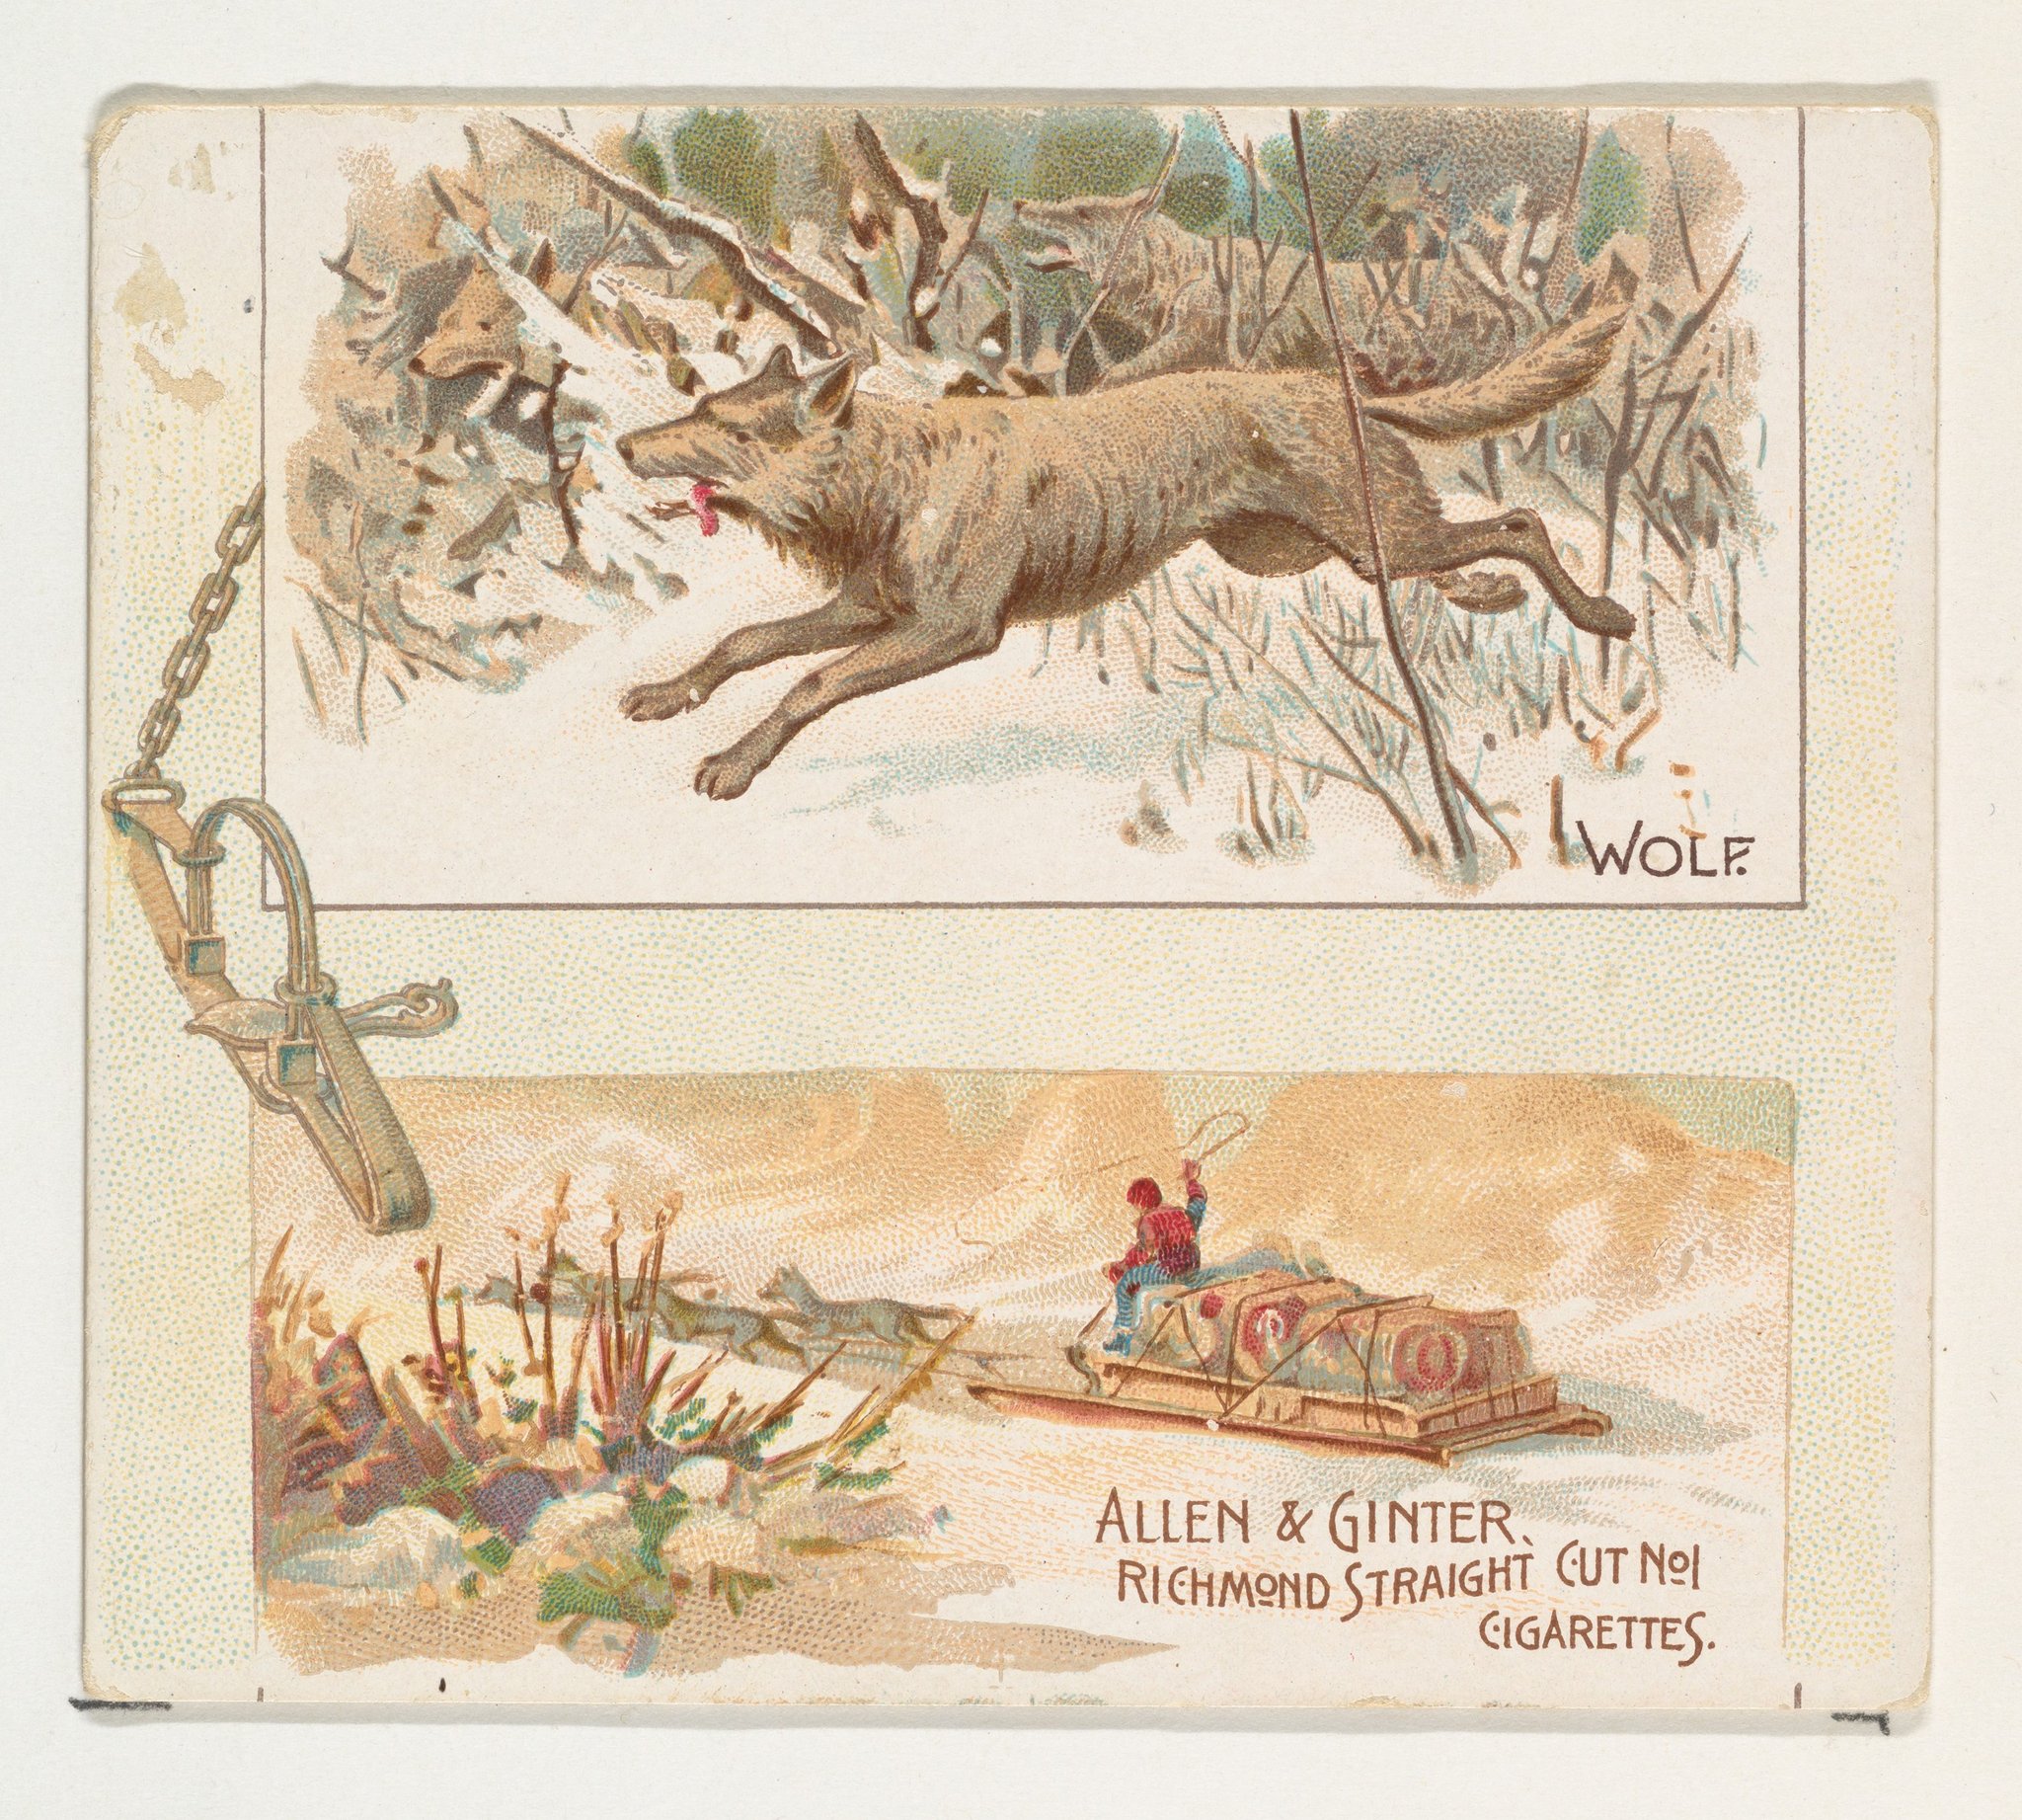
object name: print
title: Wolf, from Quadrupeds series (N41) for Allen & Ginter Cigarettes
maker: allen & ginter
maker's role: publisher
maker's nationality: american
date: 1890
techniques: color lithograph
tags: wolves